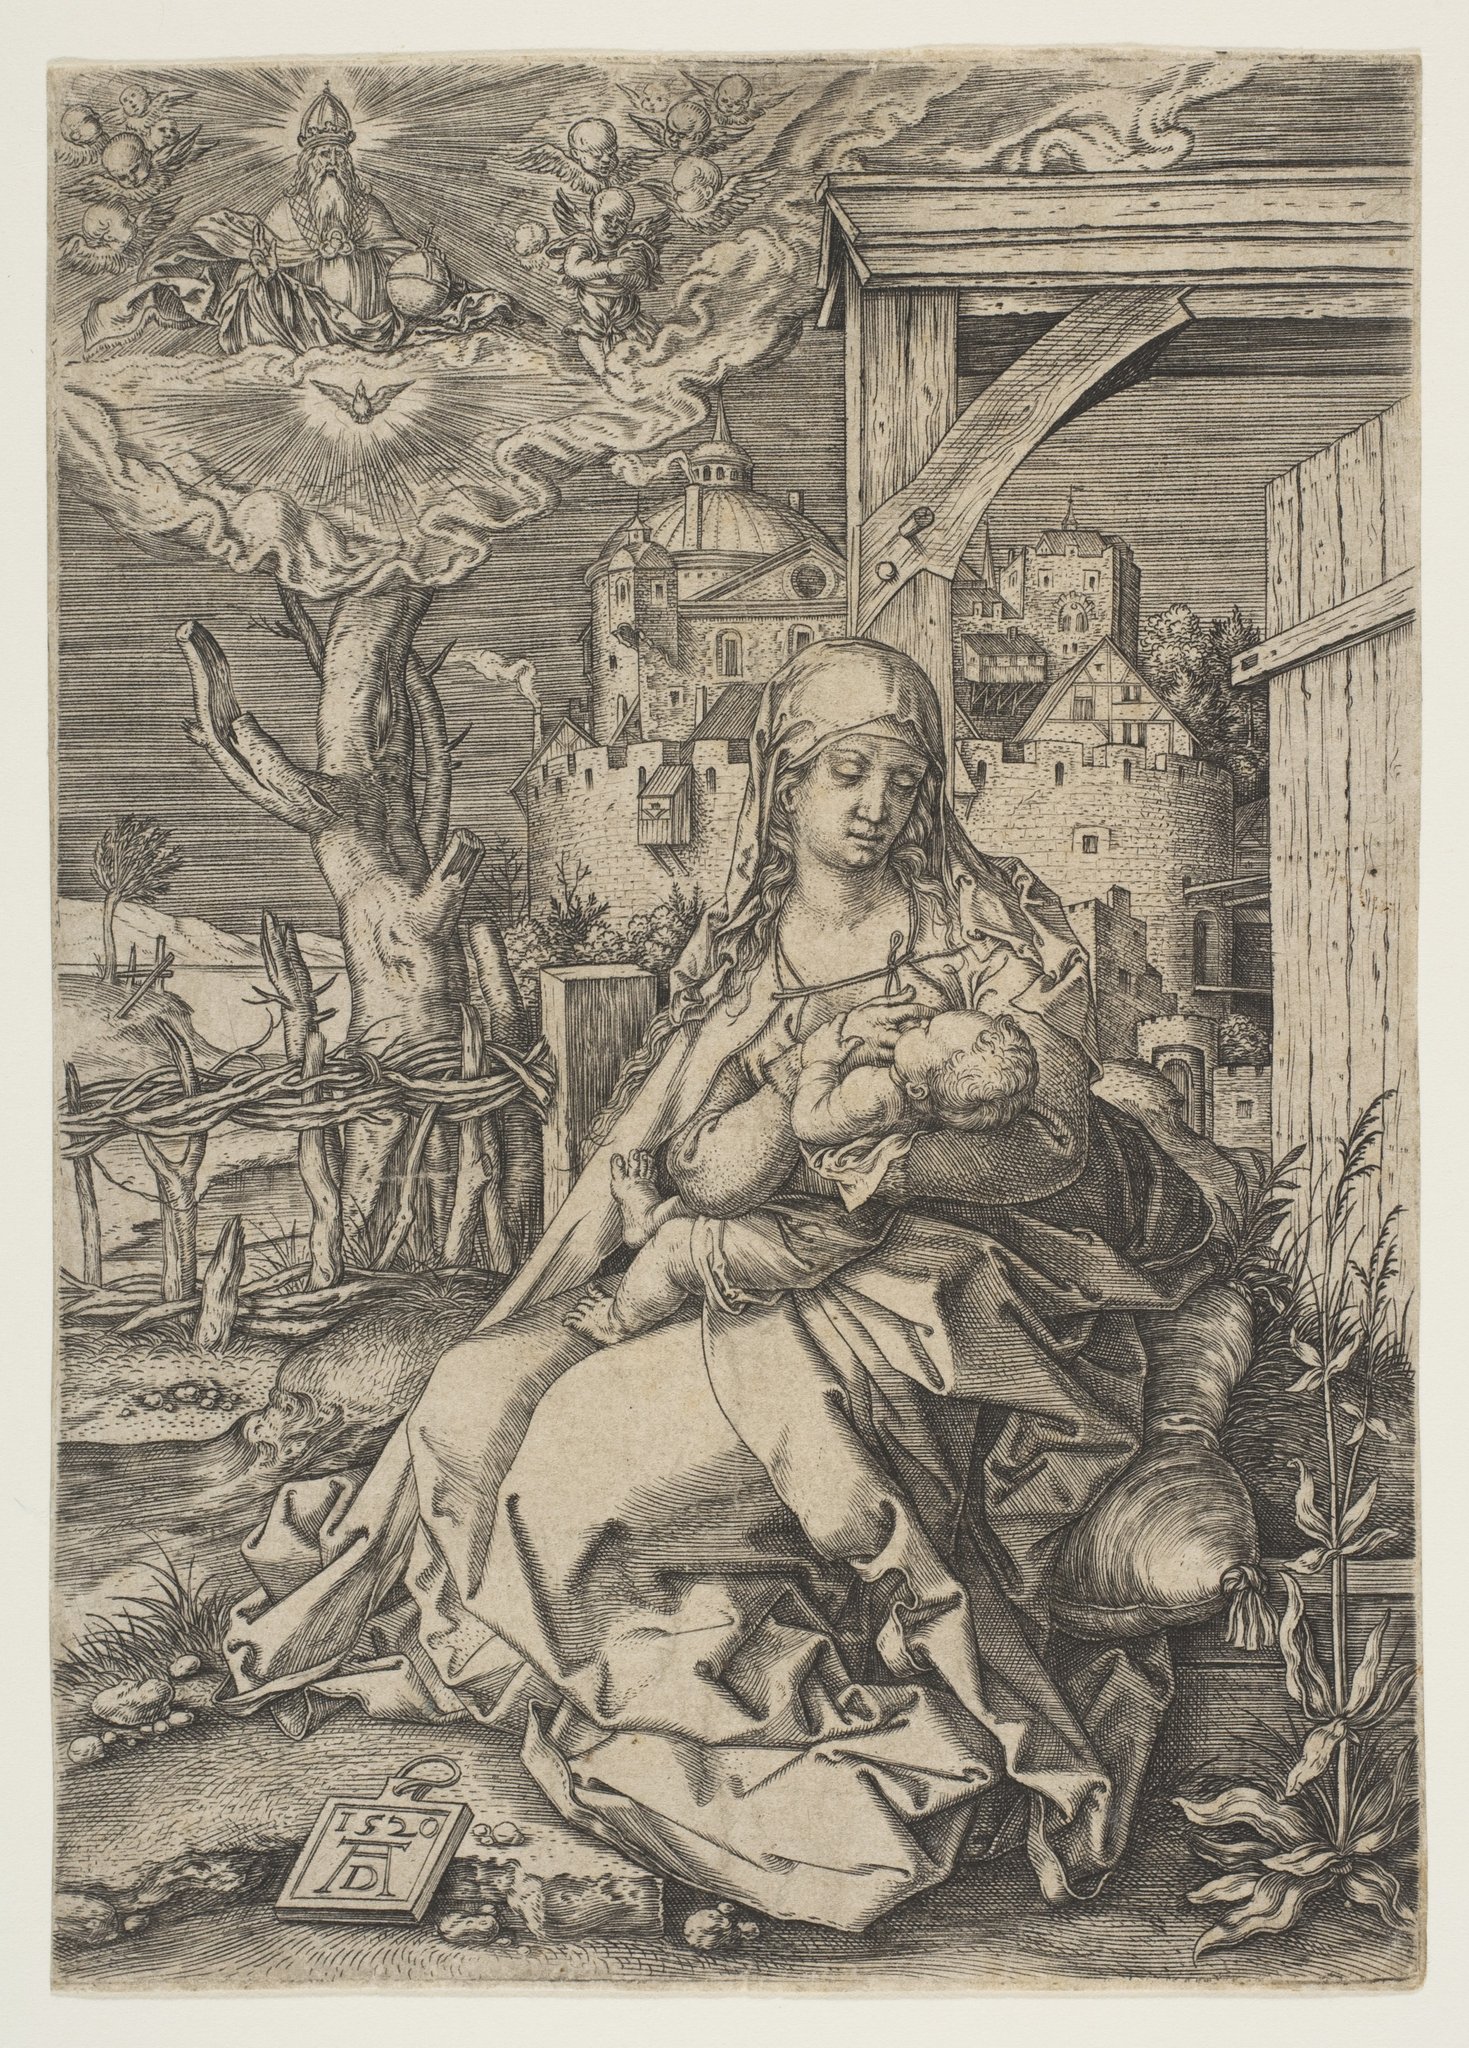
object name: print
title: Virgin and Child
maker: albrecht dürer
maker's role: artist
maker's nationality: german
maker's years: 1471-1528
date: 1520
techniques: engraving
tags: madonna and child